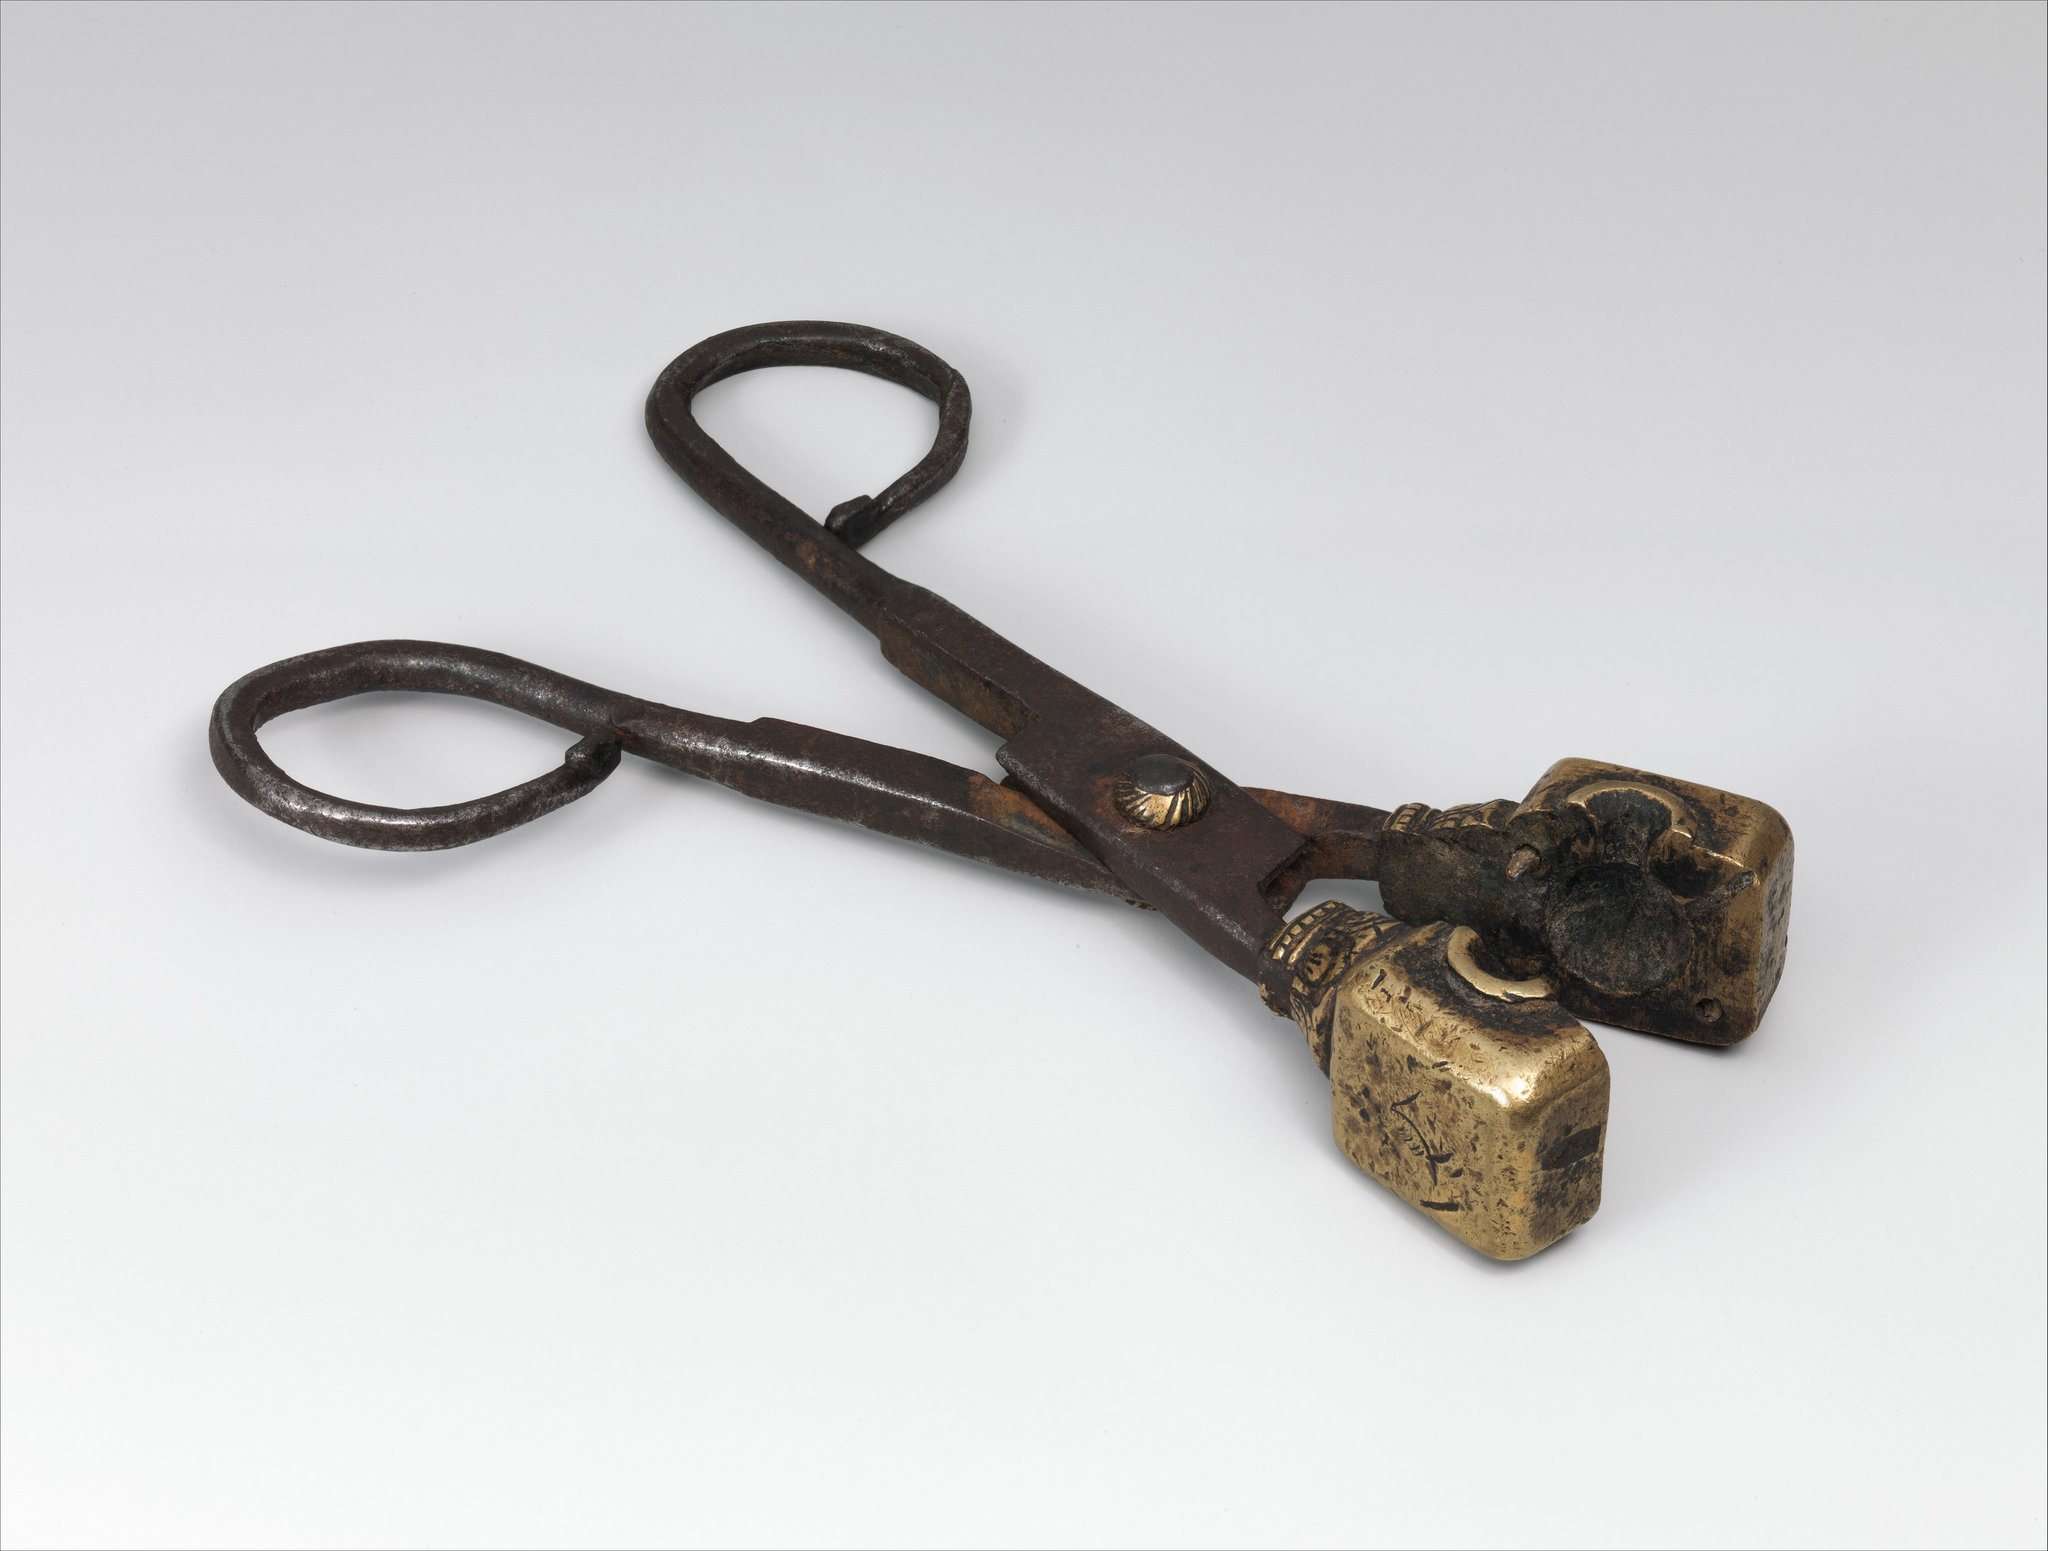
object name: bullet mould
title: Bullet Mold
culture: himalayan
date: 1601-1900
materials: brass, iron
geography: bhutan